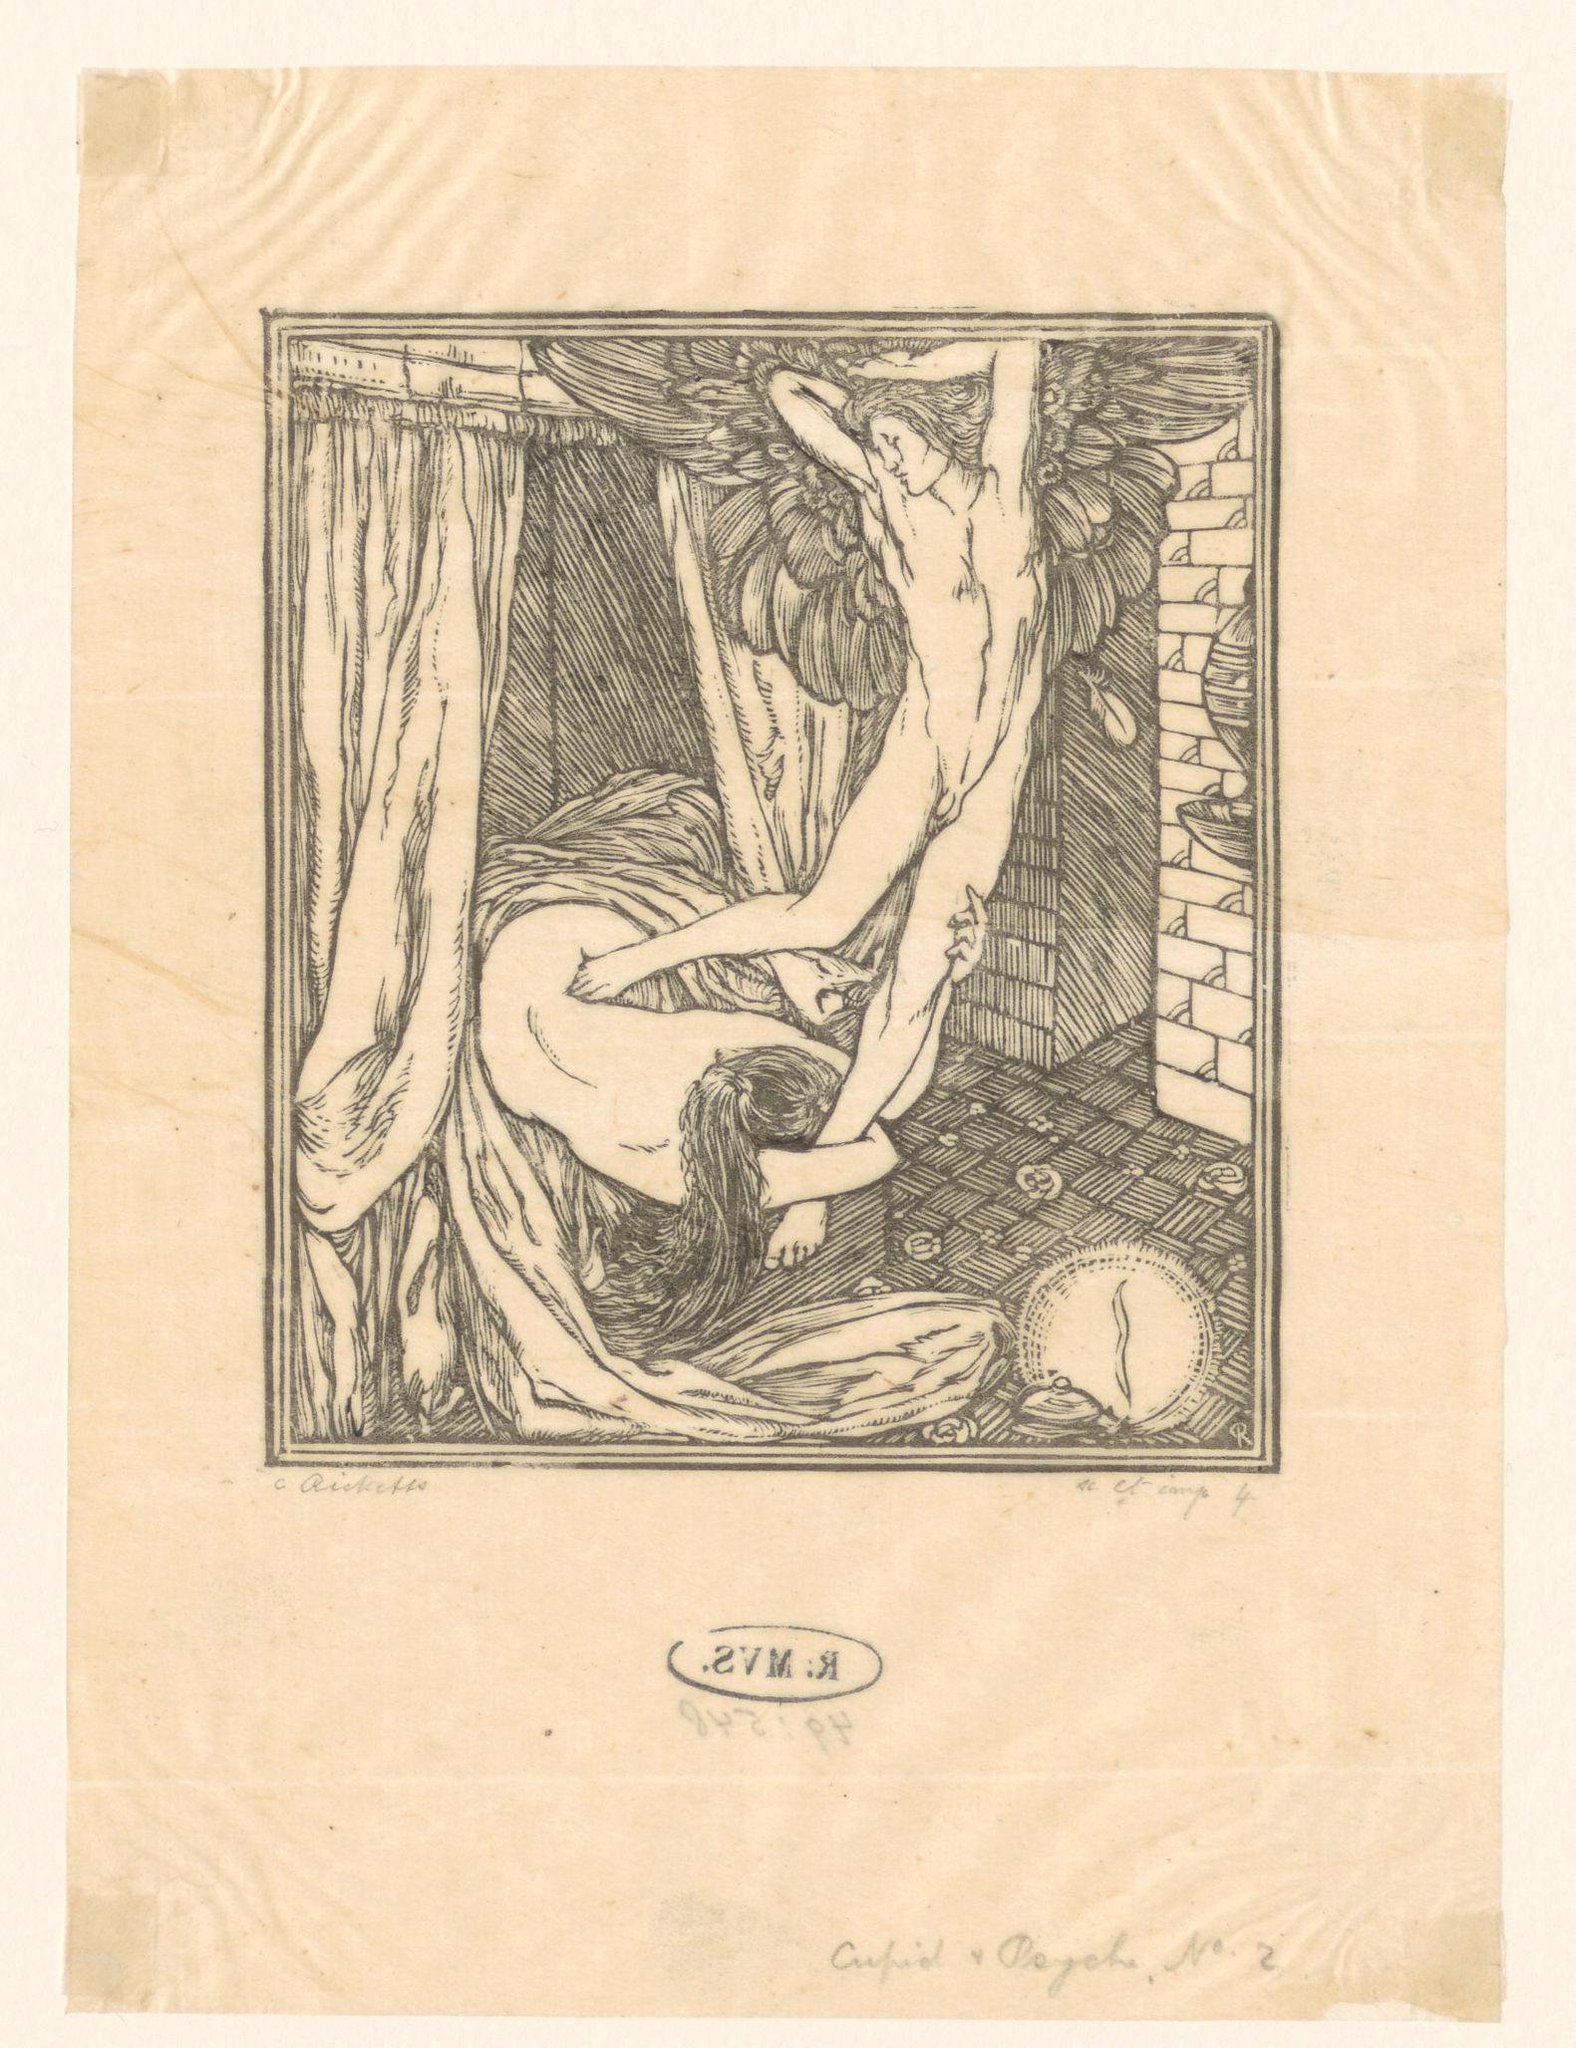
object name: print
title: Cupido ontvlucht Psyche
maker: charles ricketts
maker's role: print maker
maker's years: 1866-1931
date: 1901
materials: paper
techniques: woodcut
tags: cupid leaves the desperate psyche behind, bed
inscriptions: inscription: ‘C. Ricketts; sc. et imp. 4; Cupid u Psyche No 2.’, collector's mark: Lugt 2228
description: Prent gebruikt in: De Cupidinis et Psyches Amoribus. Londen: The Vale Press, 1901. Mogelijk gaat het om een proefdruk.